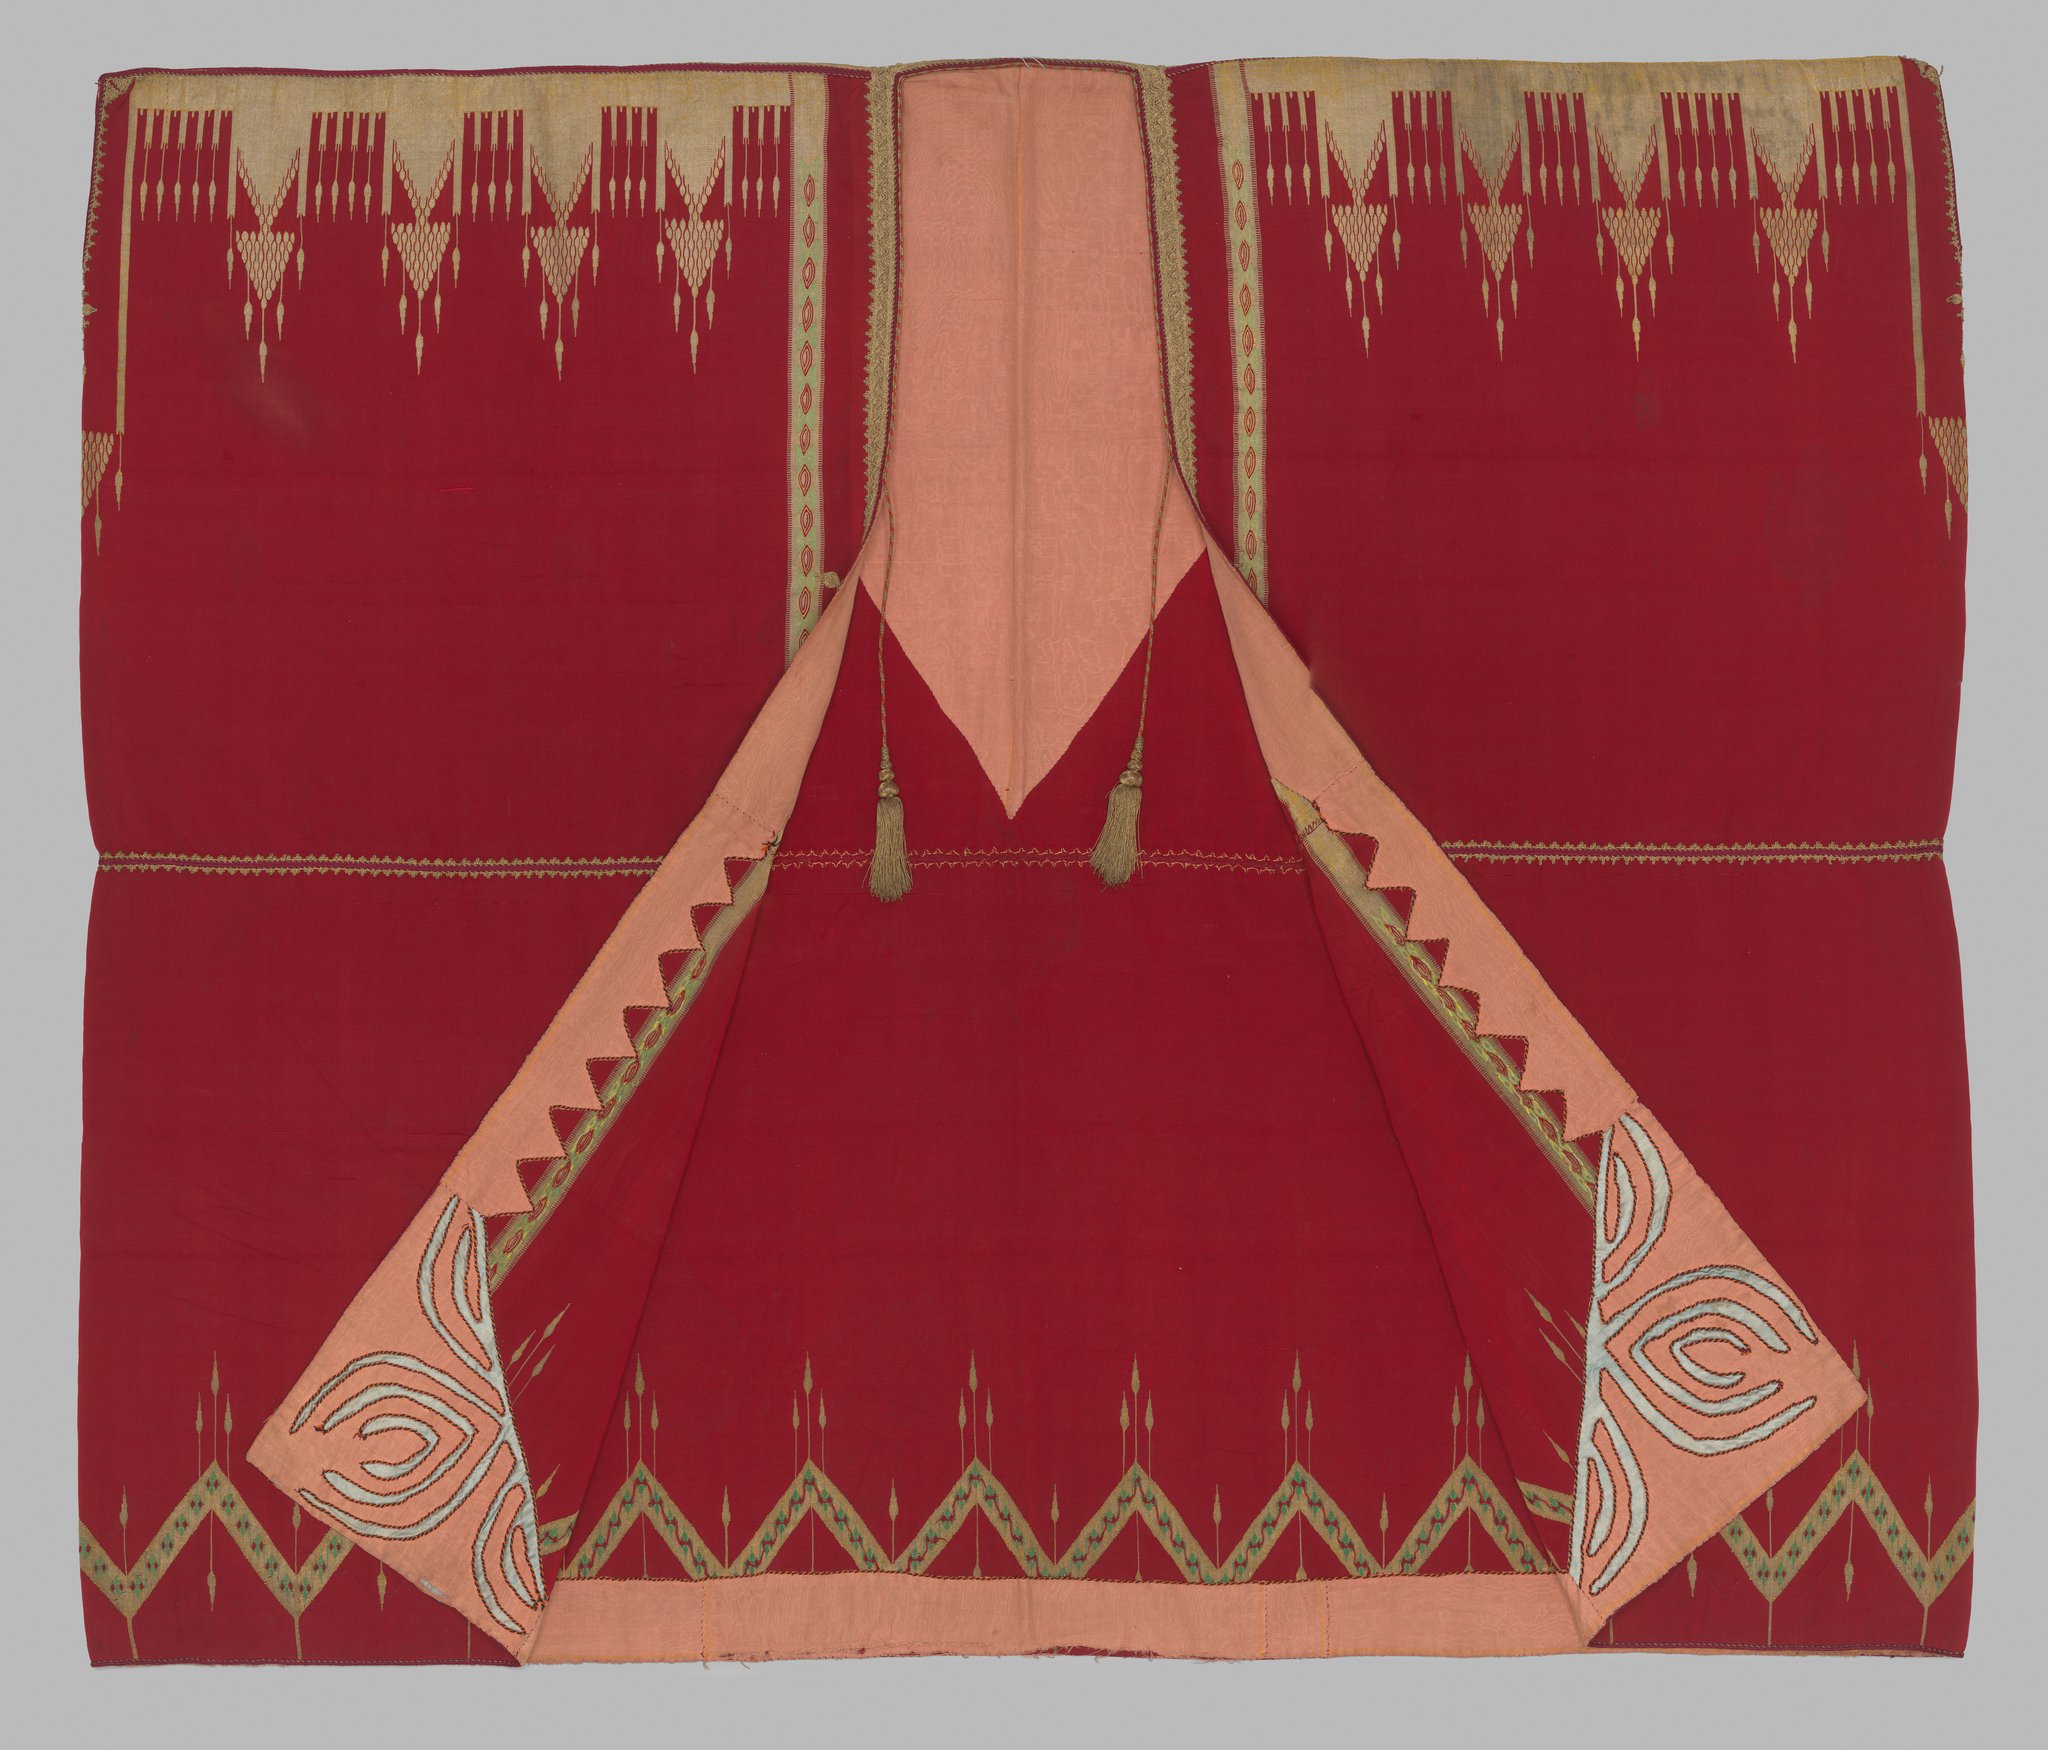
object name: cloak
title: Abaya Cloak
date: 1867-1933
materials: cotton, metal thread, silk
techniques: embroidery, weave, satin weave, tapestry weave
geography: syria